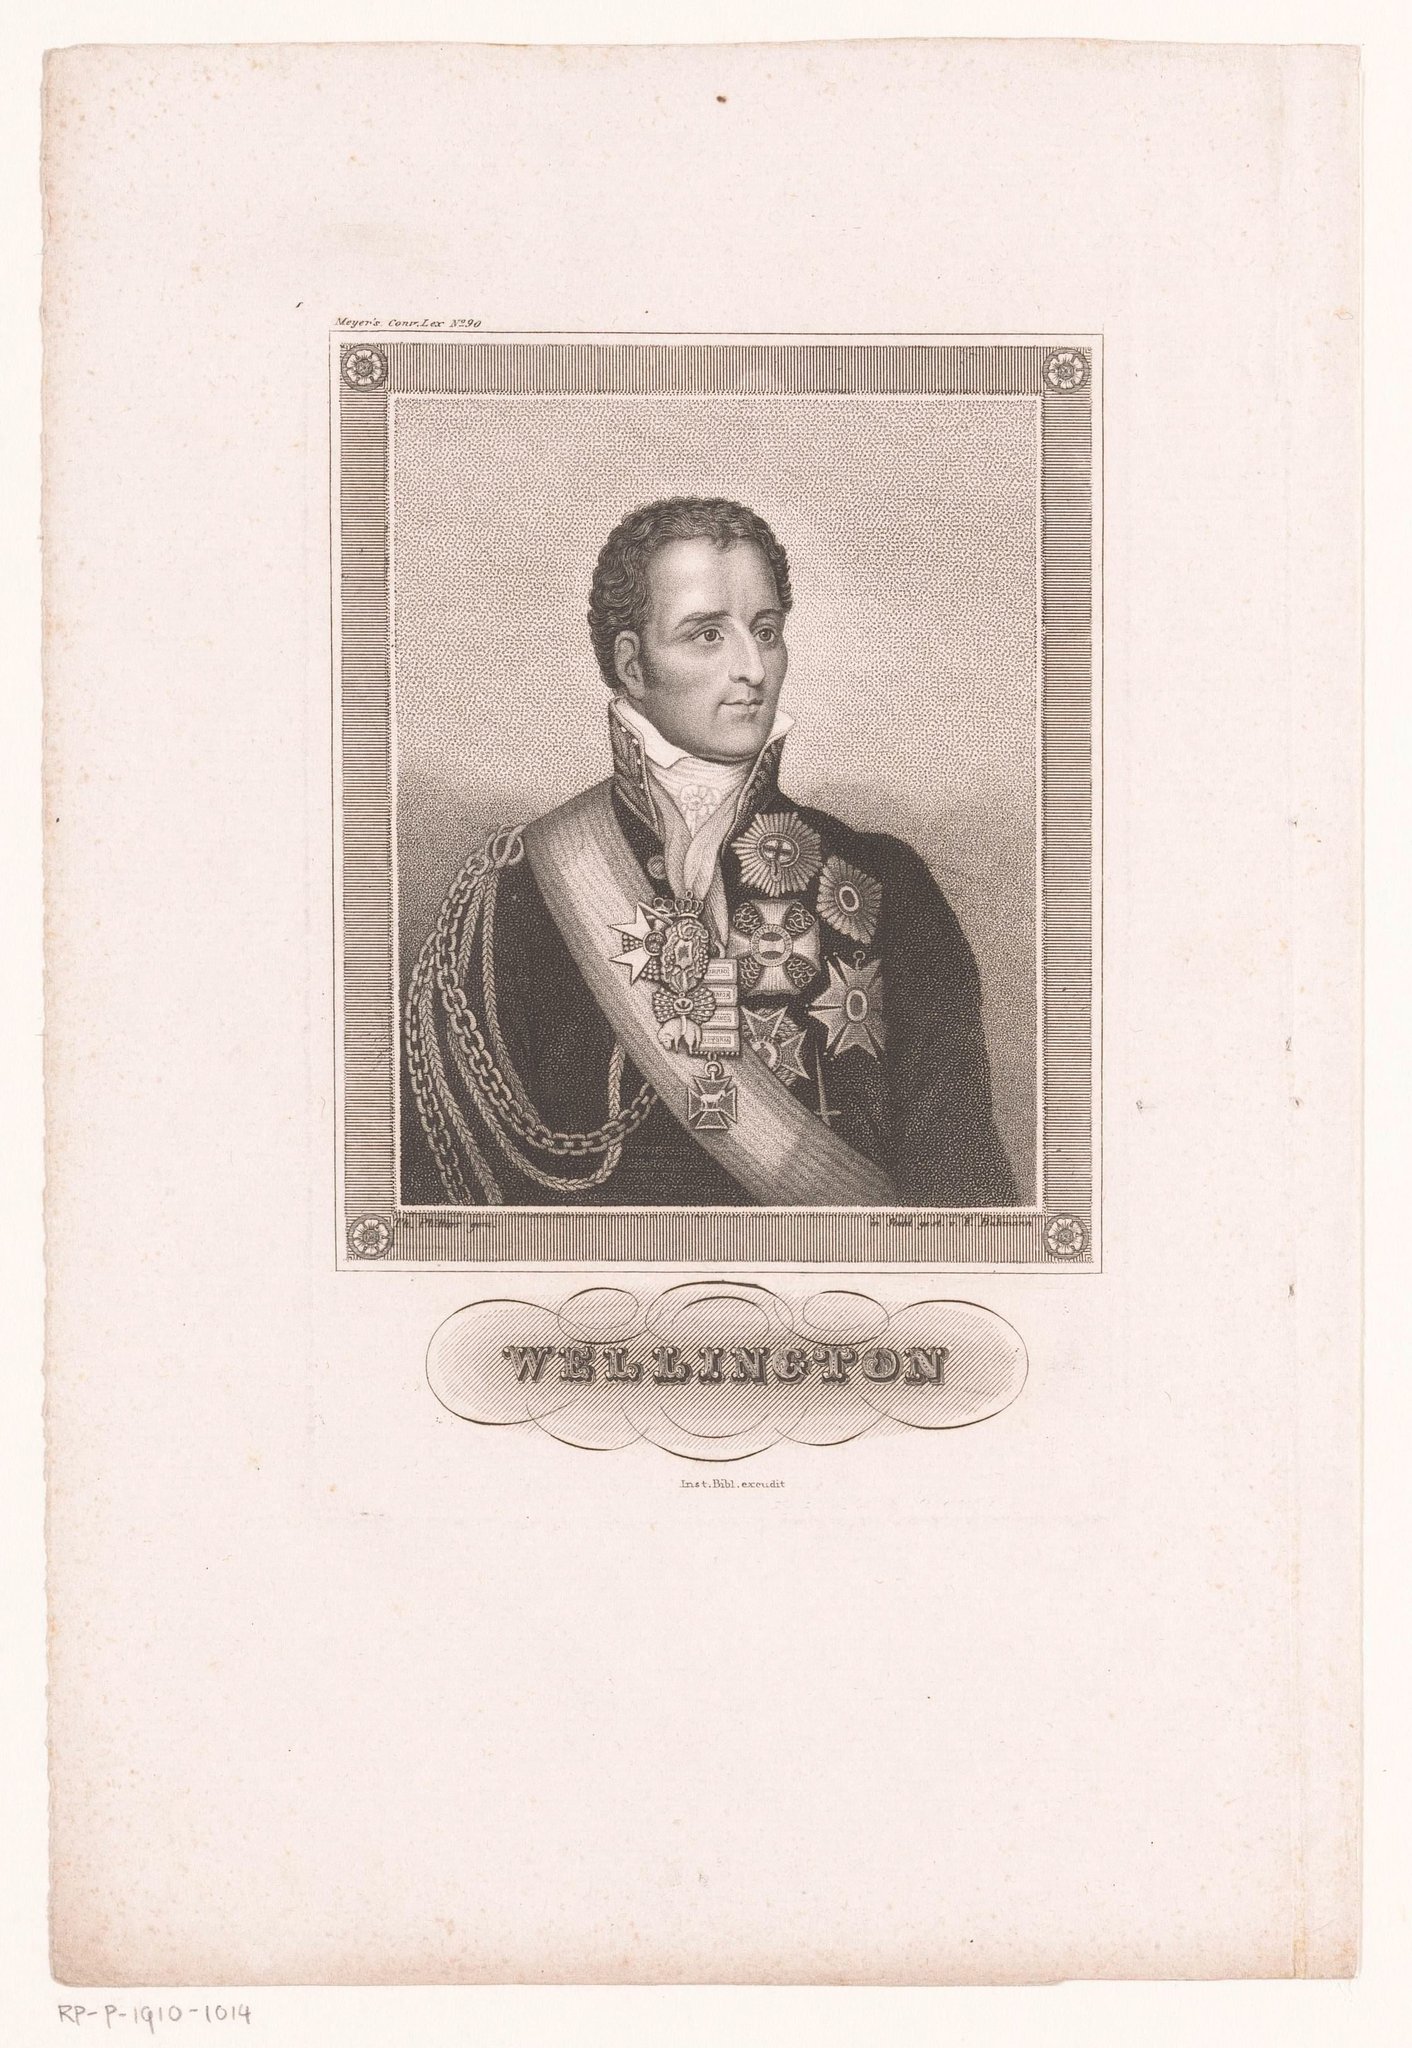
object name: book illustration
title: Wellington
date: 1840-1855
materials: paper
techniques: engraving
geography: hildburghausen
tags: walmer castle, arthur wellesley of wellington, historical persons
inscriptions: collector's mark: Lugt 2228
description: Prent afkomstig uit: Meyer, Joseph. Das große Conversations-Lexikon für die gebildeten Stände.